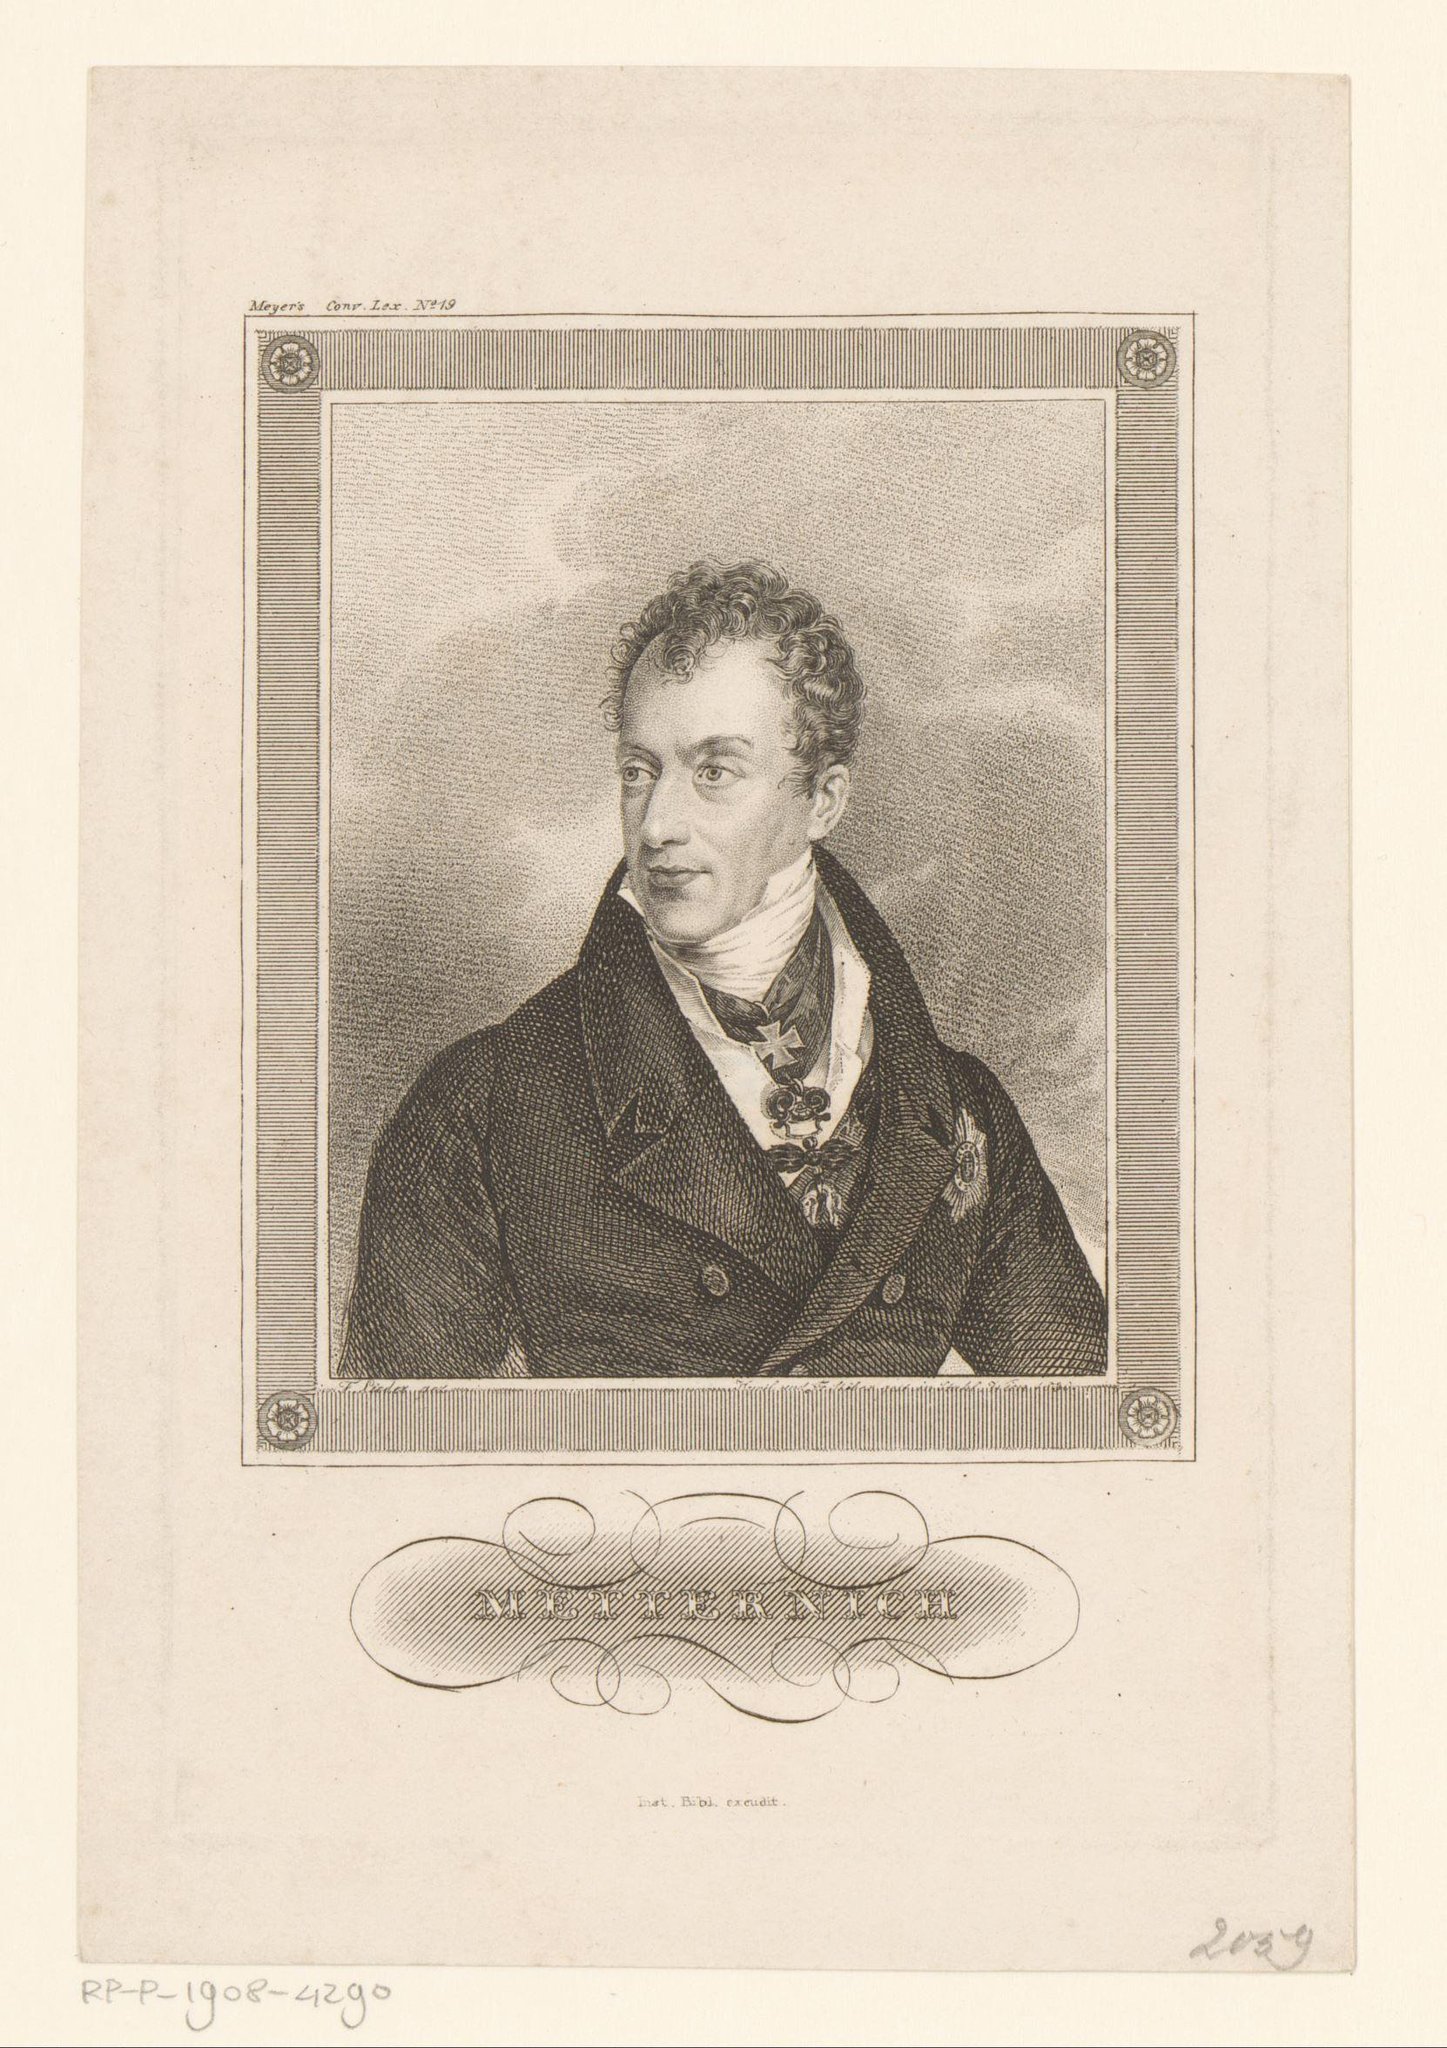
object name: book illustration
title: Portret van Klemens Wenzel Lothar, Fürst von Metternich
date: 1830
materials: paper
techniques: engraving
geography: vienna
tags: vienna, historical persons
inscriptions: collector's mark: Lugt 2228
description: Prent afkomstig uit: Conversations-Lexikon für die gebildeten Stände, voor het eerst uitgegeven tussen 1840-1855.